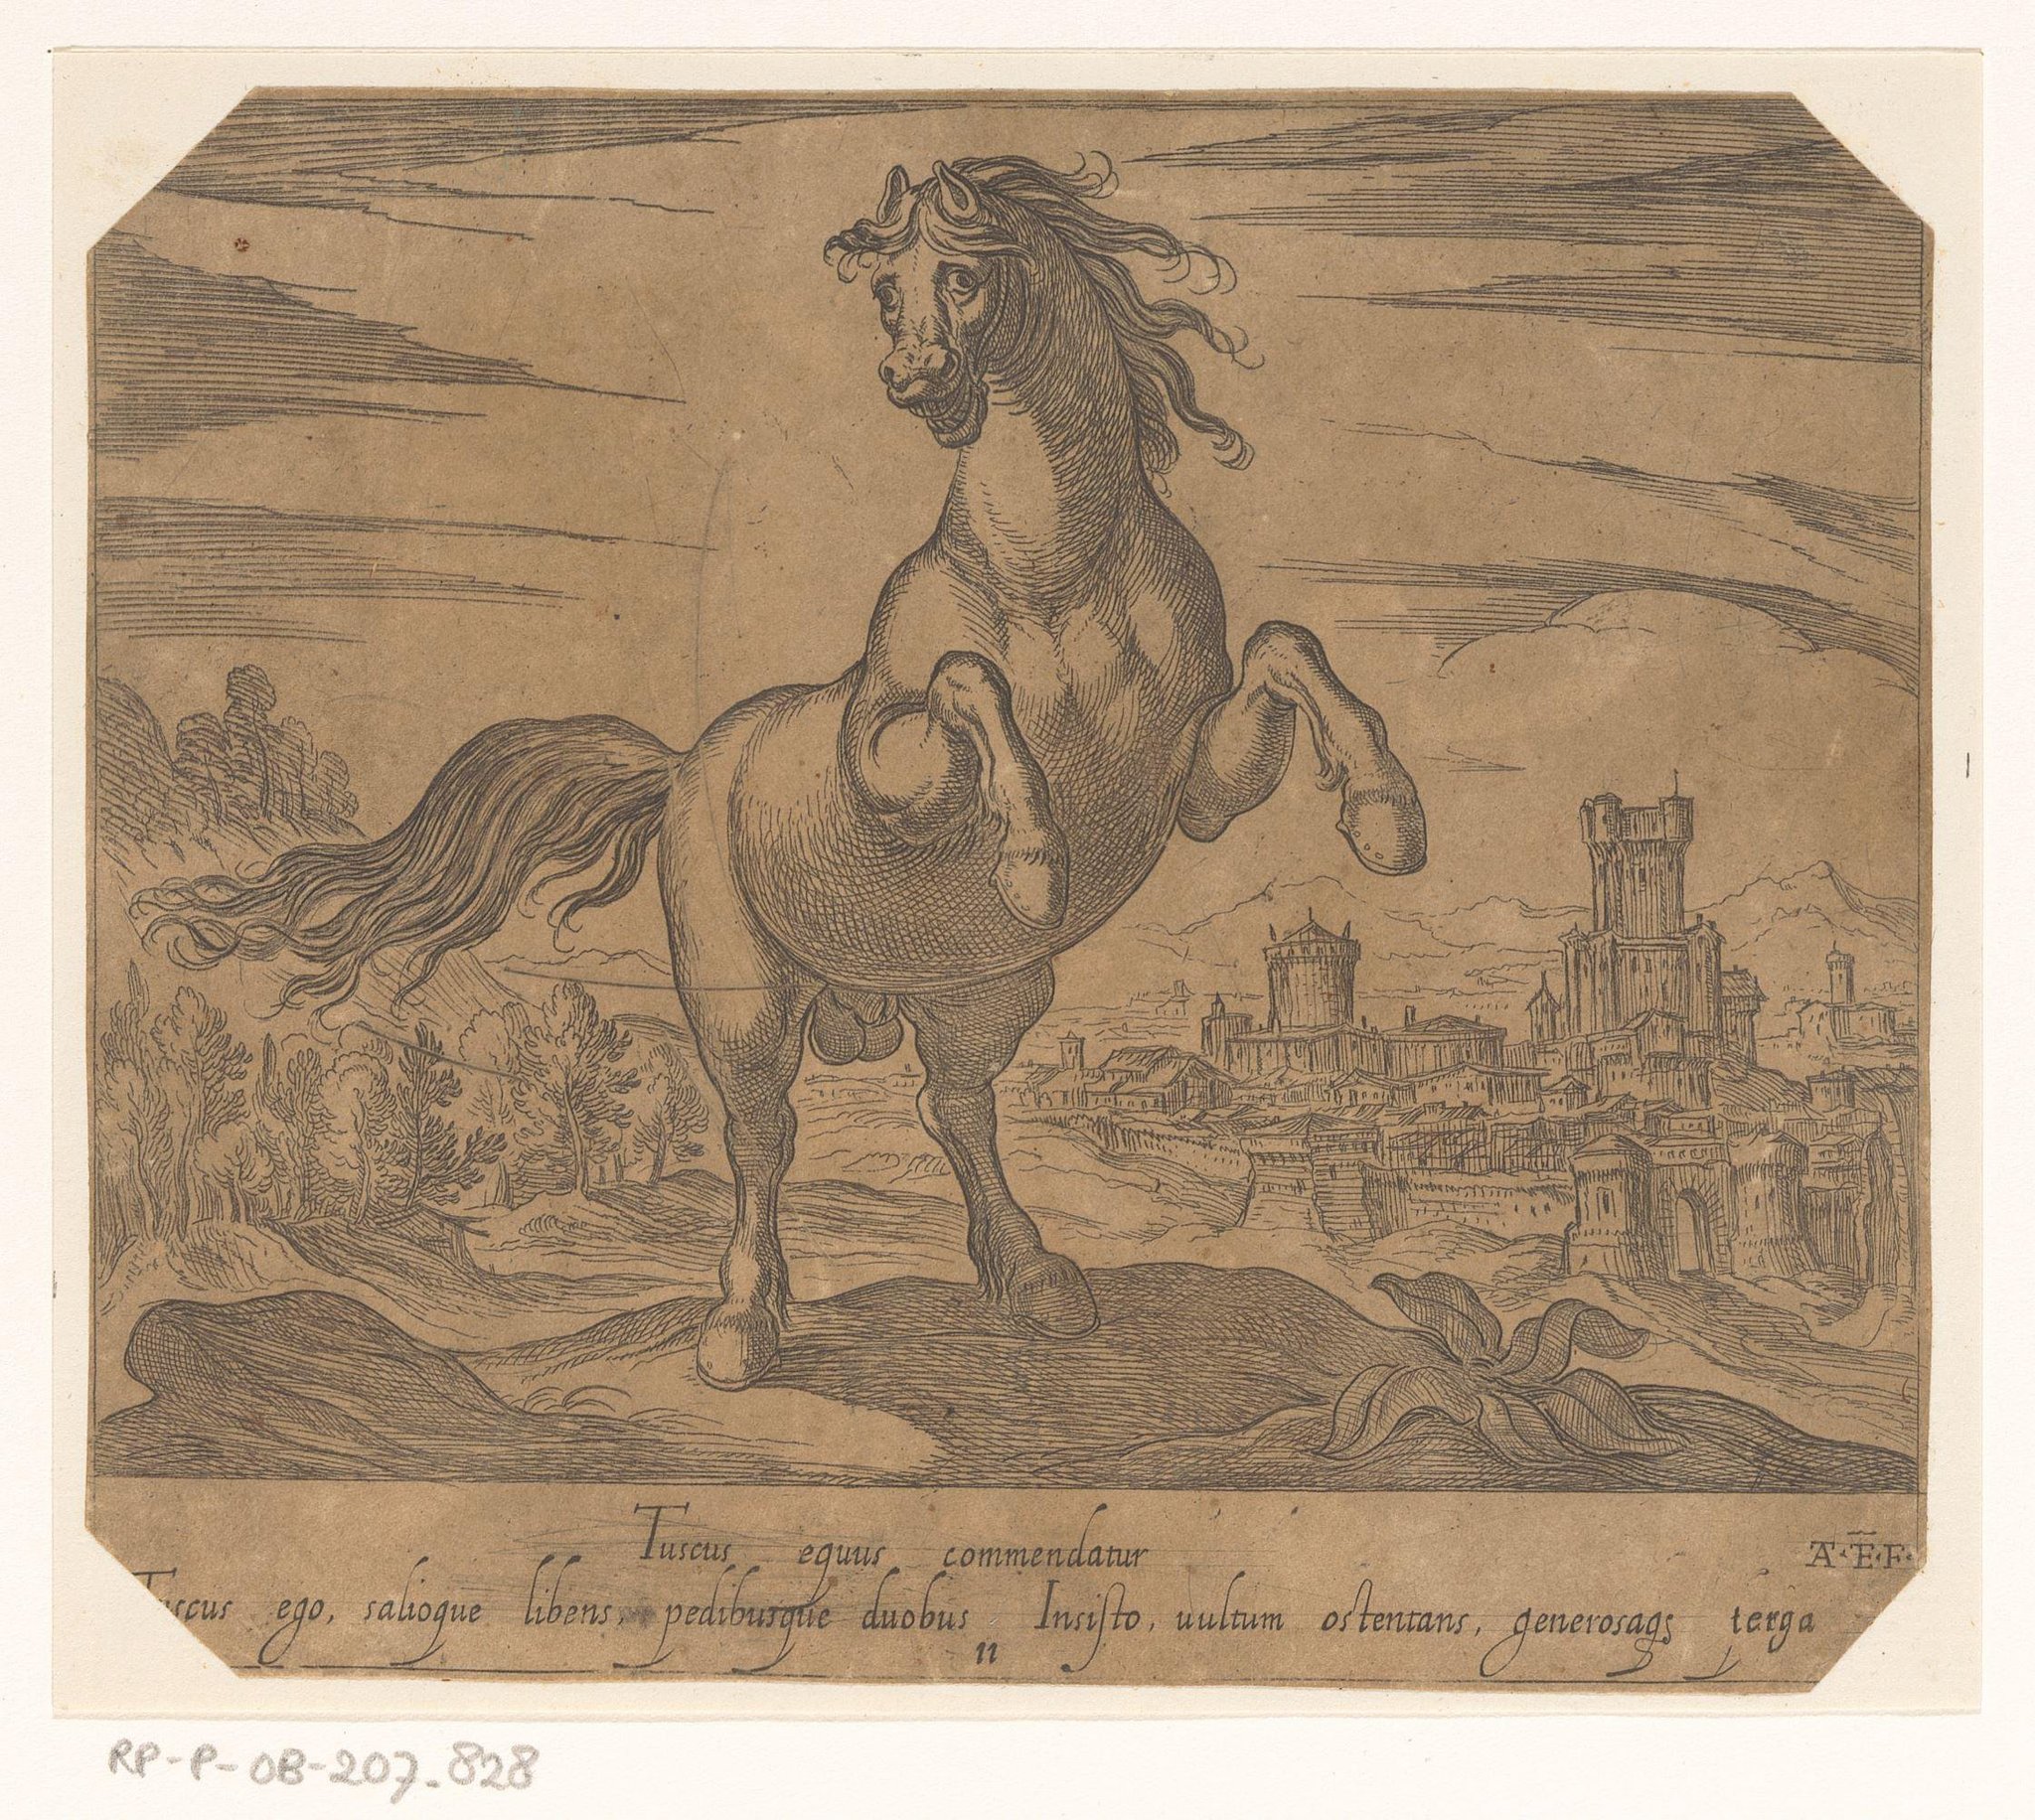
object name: print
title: His ducibus princeps celebraberis ore viroru illa homines beat haec sideribusq locat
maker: antonio tempesta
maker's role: draughtsman, painter, print maker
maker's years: 1555-1630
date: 1590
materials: paper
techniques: etching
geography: italy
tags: horse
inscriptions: collector's mark: Lugt 2228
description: Deze prent maakt deel uit van een reeks van 28 prenten van paarden (+ titelprent en opdracht).